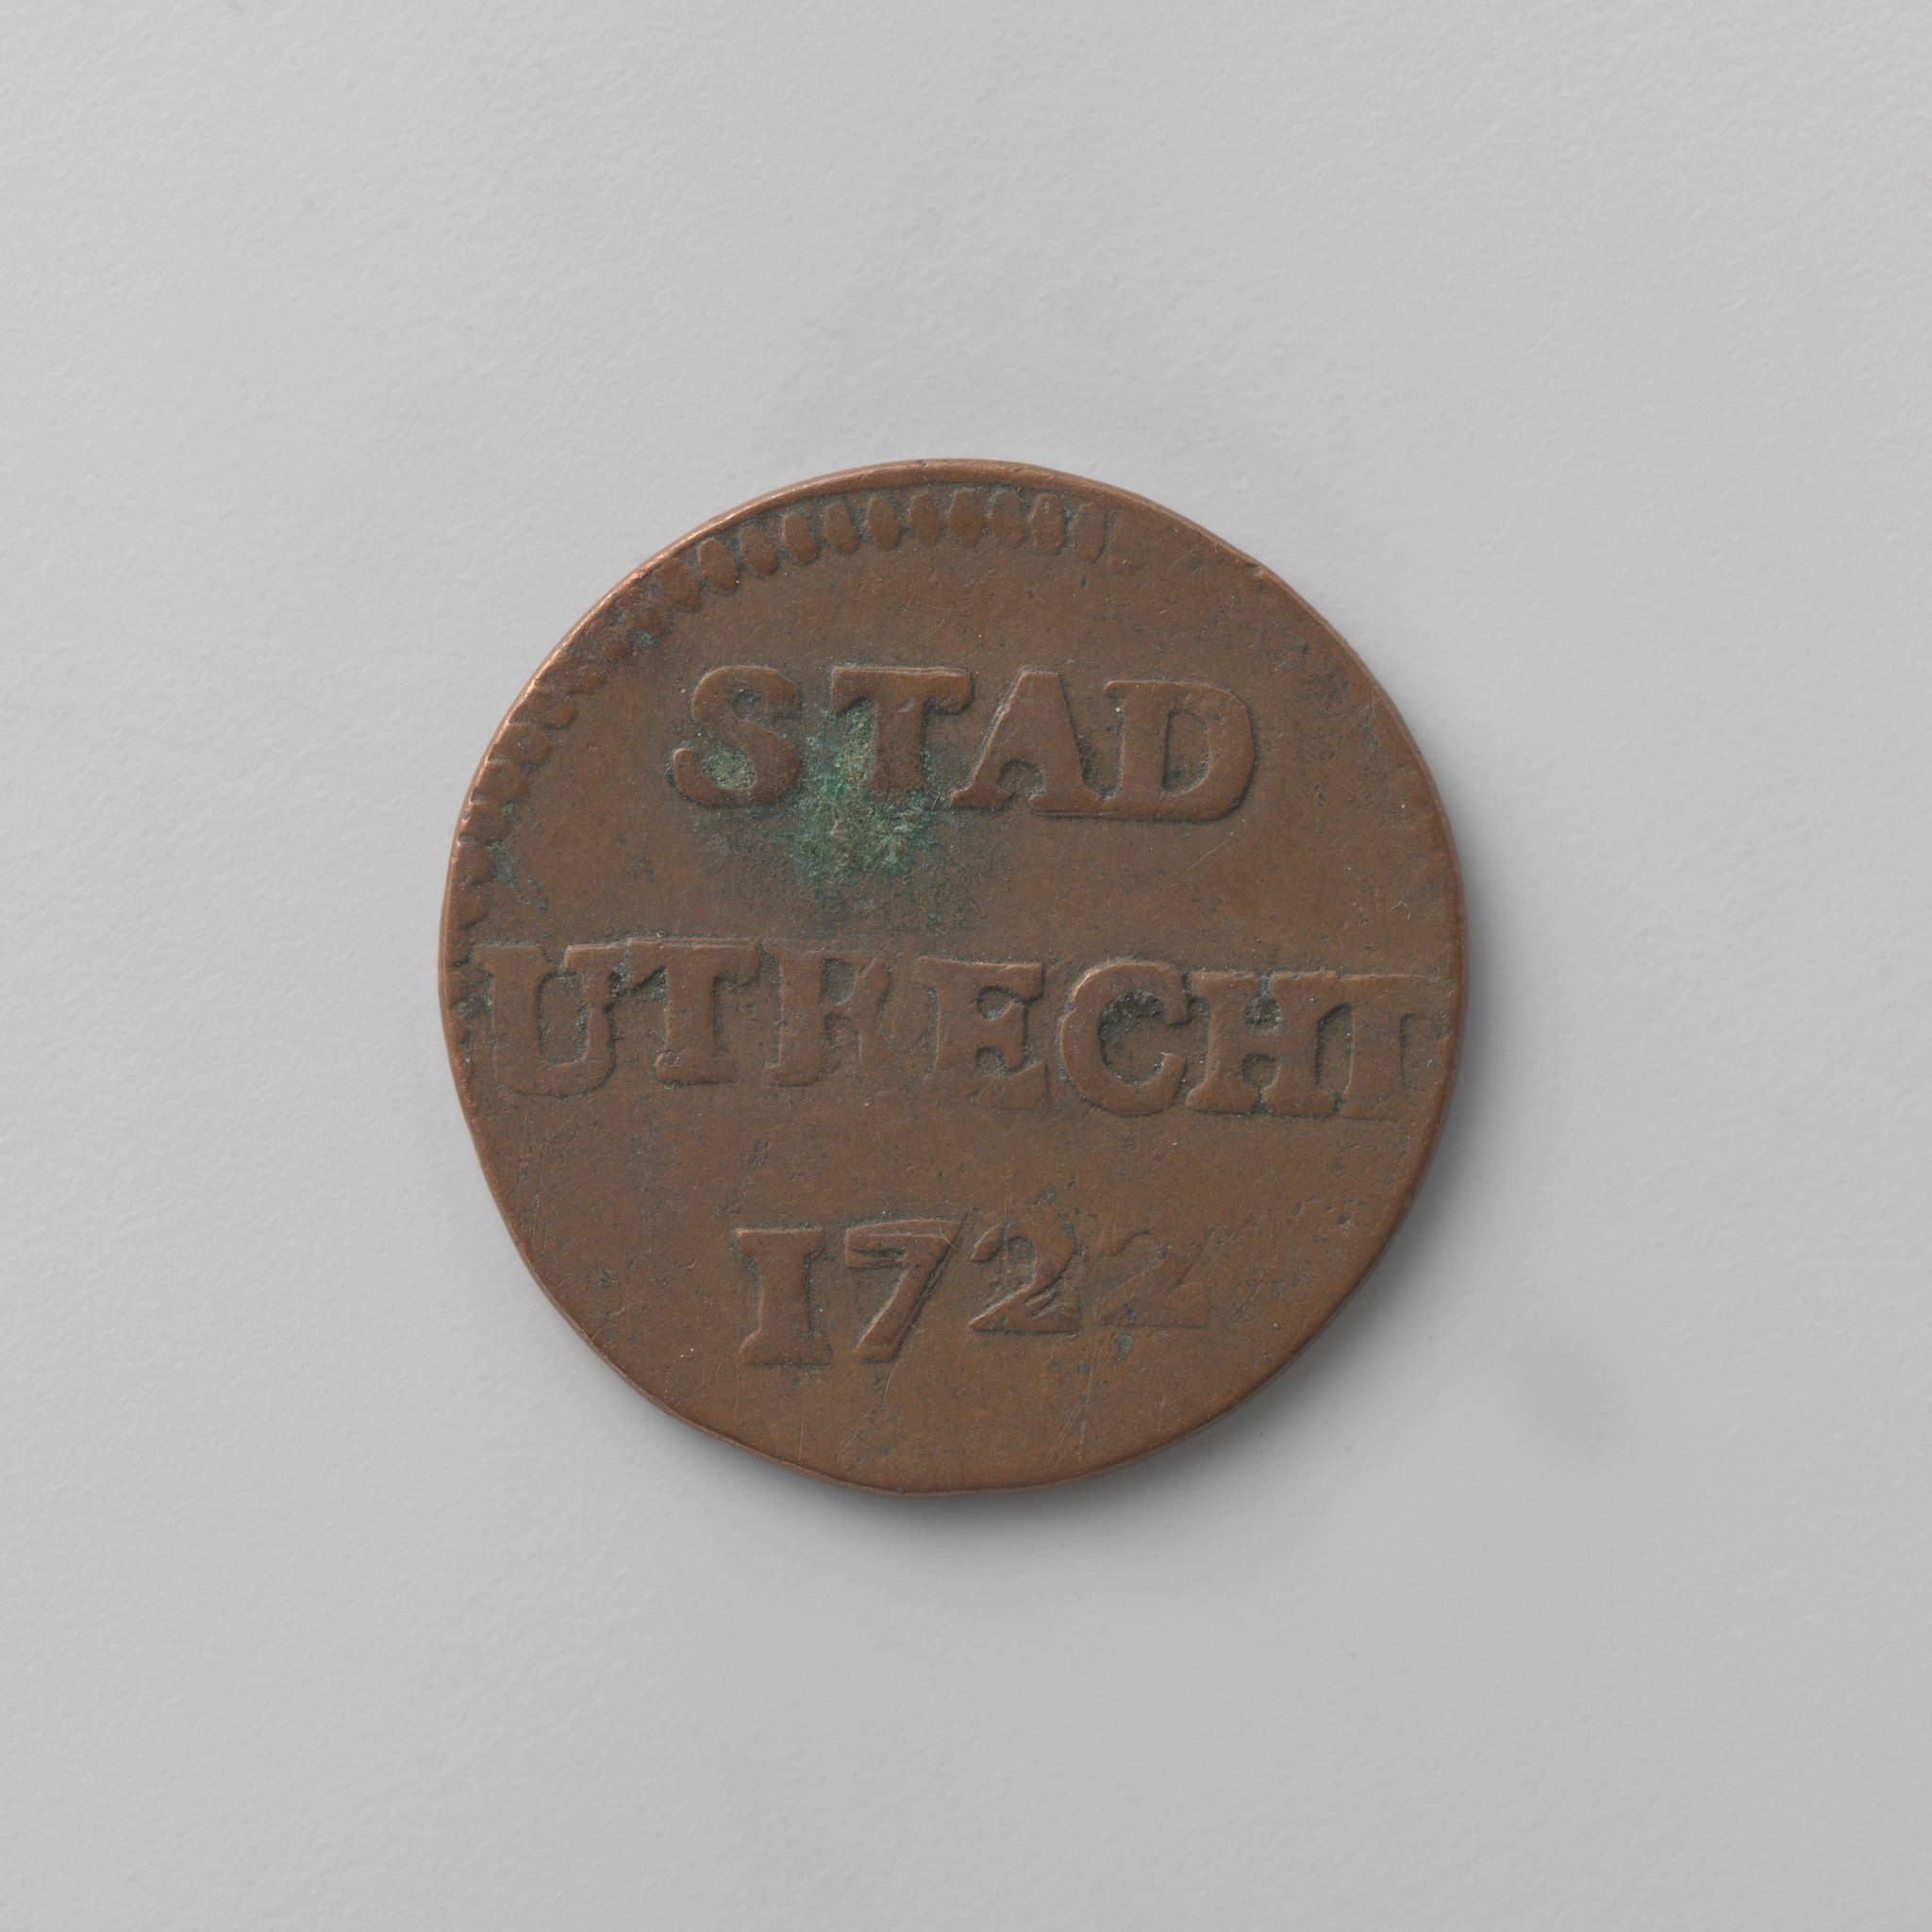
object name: coin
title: Duit van de stad Utrecht, 1722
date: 1722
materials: copper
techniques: striking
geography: utrecht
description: Koperen munt. Voorzijde: gekroond stedelijk wapenschild. Keerzijde: opschrift in twee regels, waaronder jaartal.